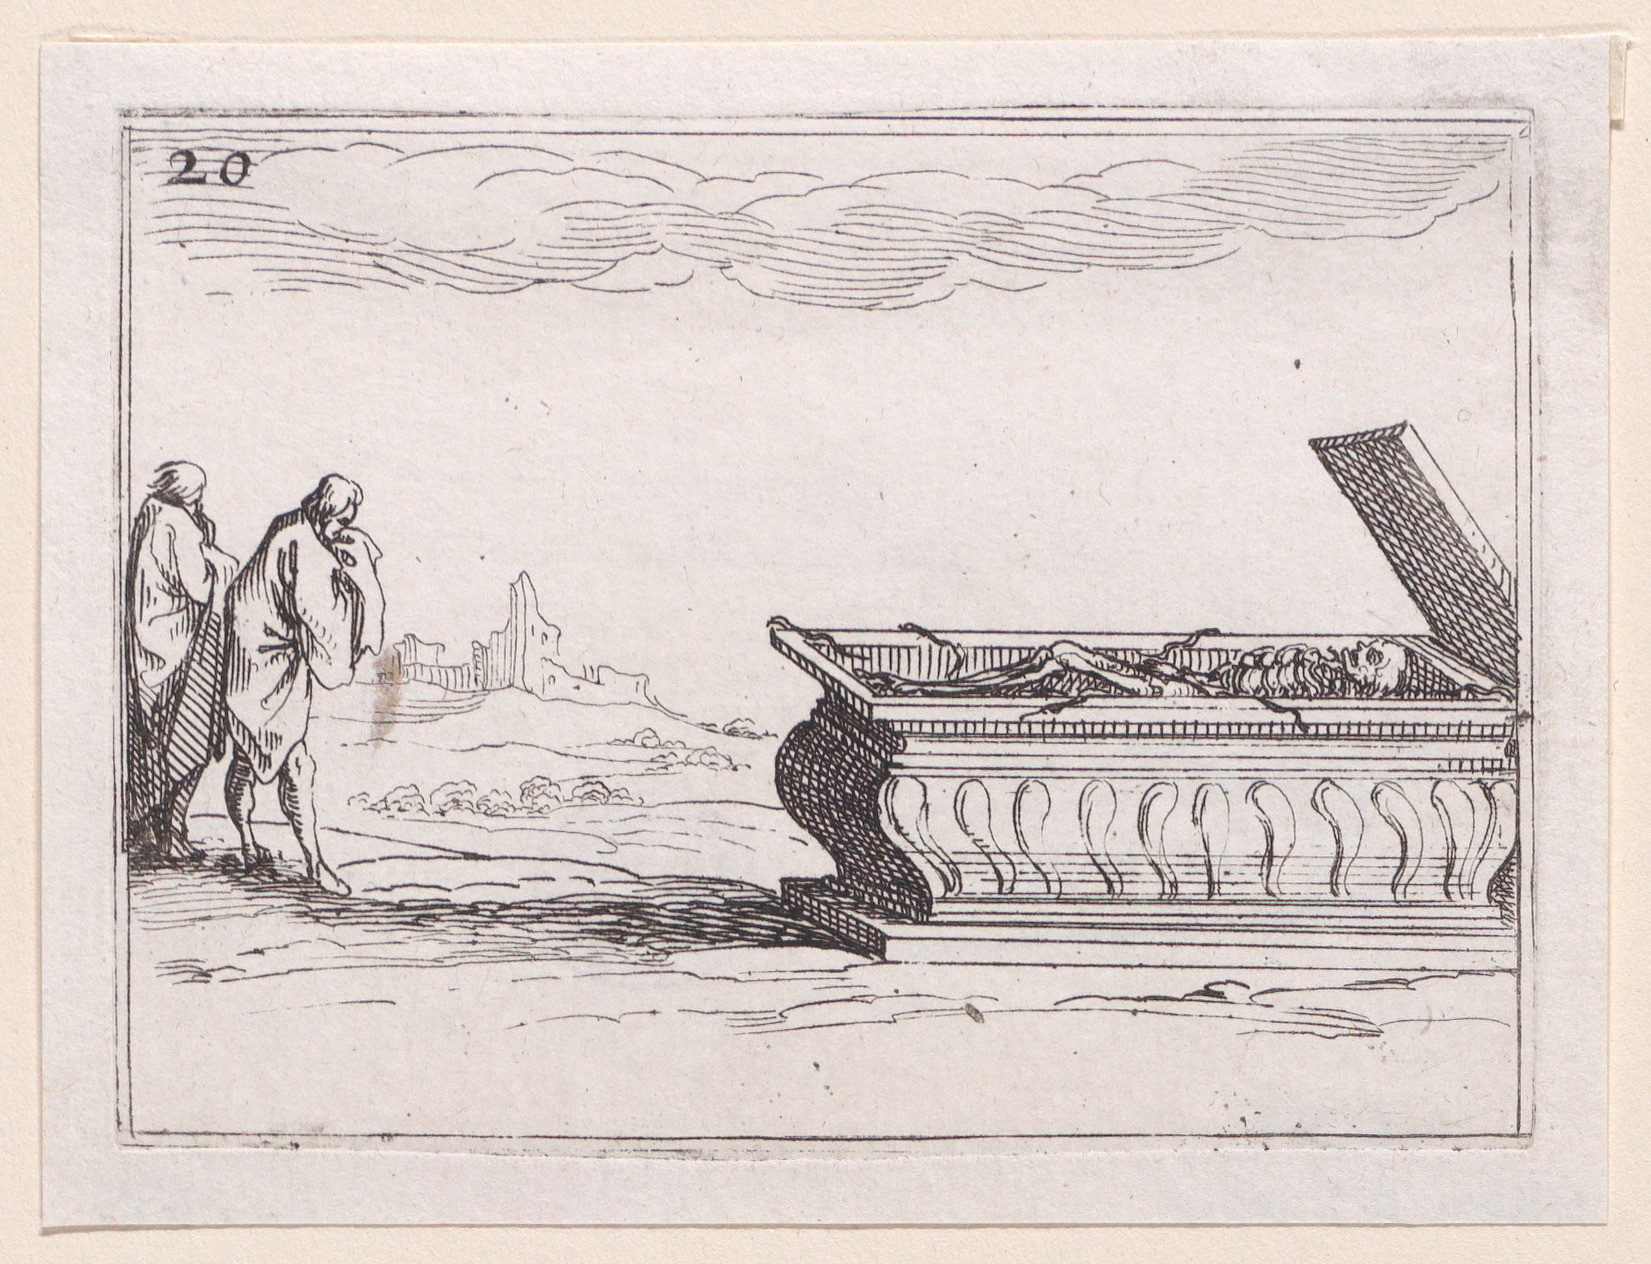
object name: print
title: Le Tombeau (The Tomb), plate 20 from "Lux Claustri ou La Lumière du Cloitre" (The Light of the Cloisters)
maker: jacques callot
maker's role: artist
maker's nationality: french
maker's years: 1592-1635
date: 1621-1635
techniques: etching